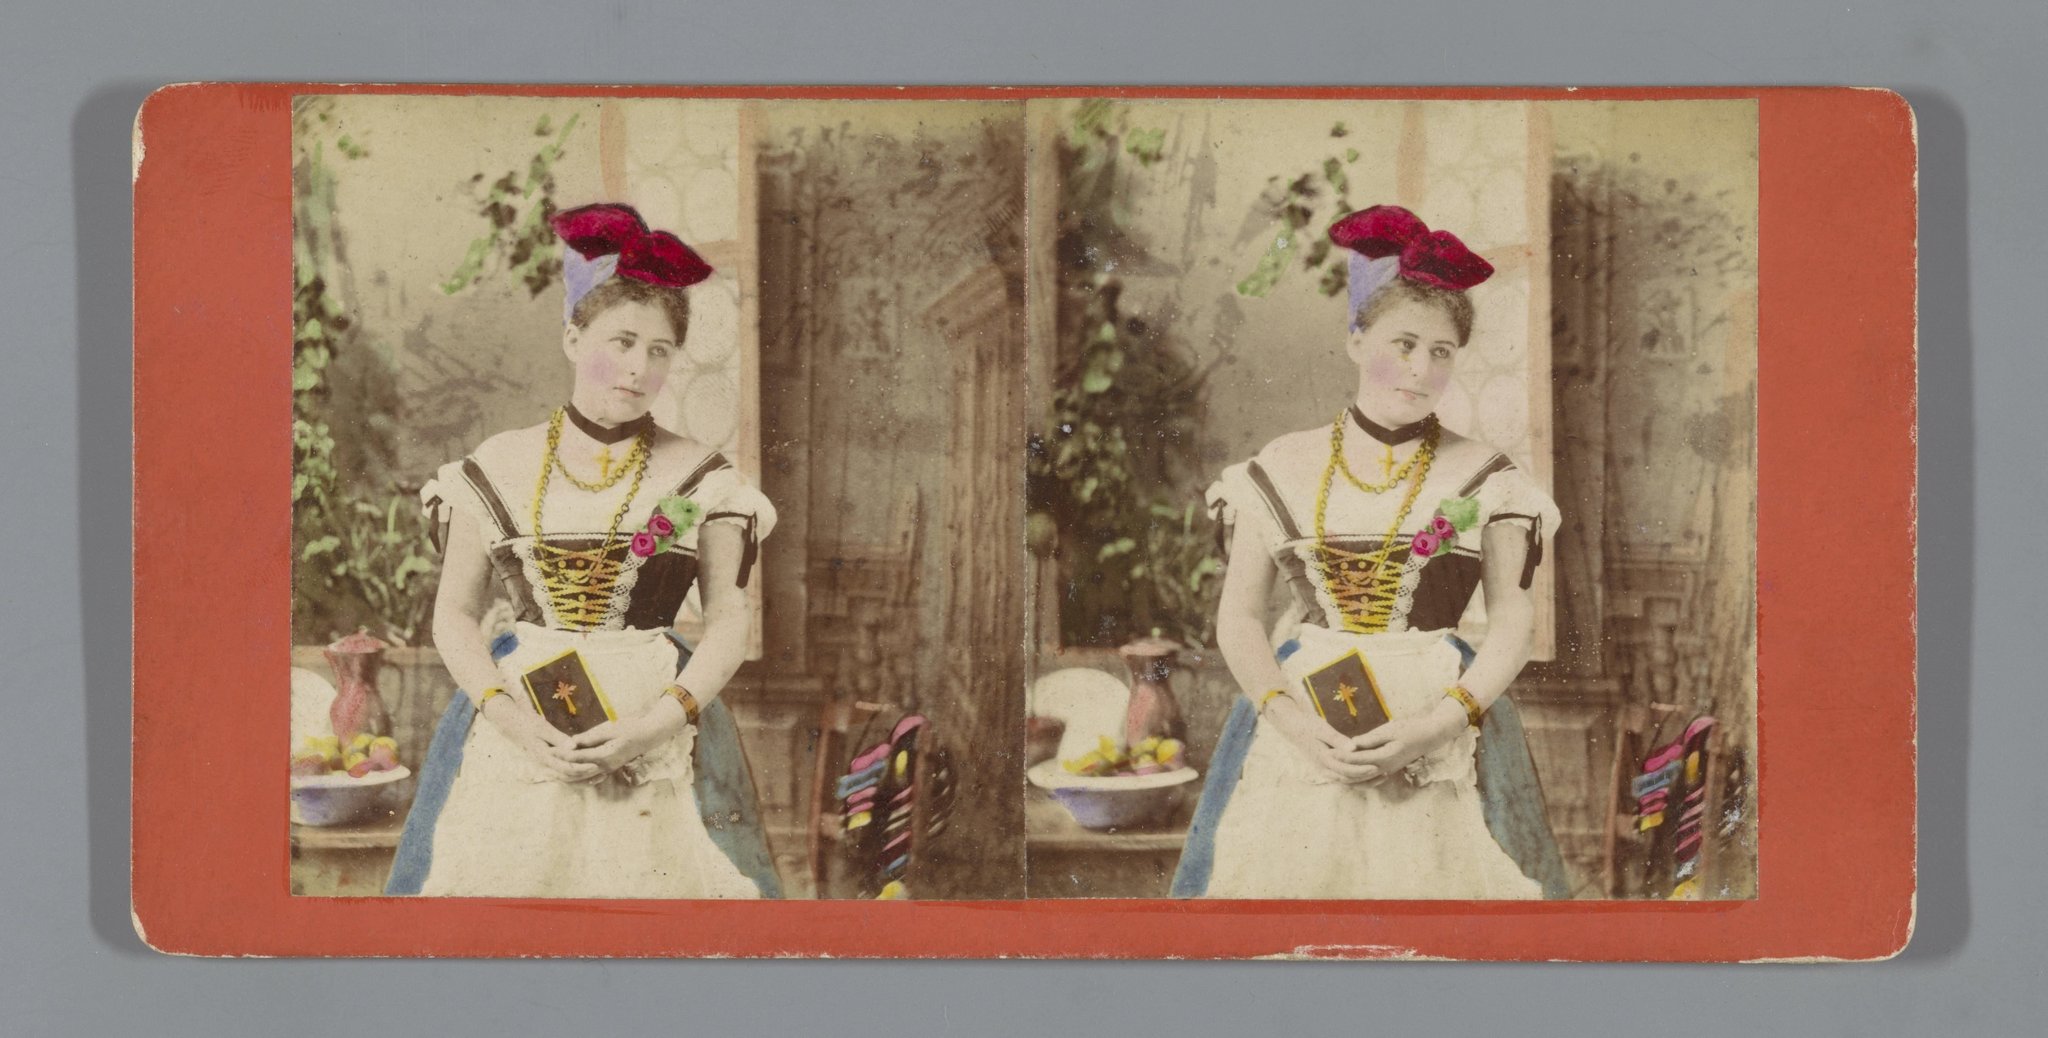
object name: stereograph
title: Vrouw met een bijbel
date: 1868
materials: cardboard, paper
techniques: albumen print, hand coloring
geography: berlin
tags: adult woman, bible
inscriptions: inscription: ‘173/17 1/2/ 65e’